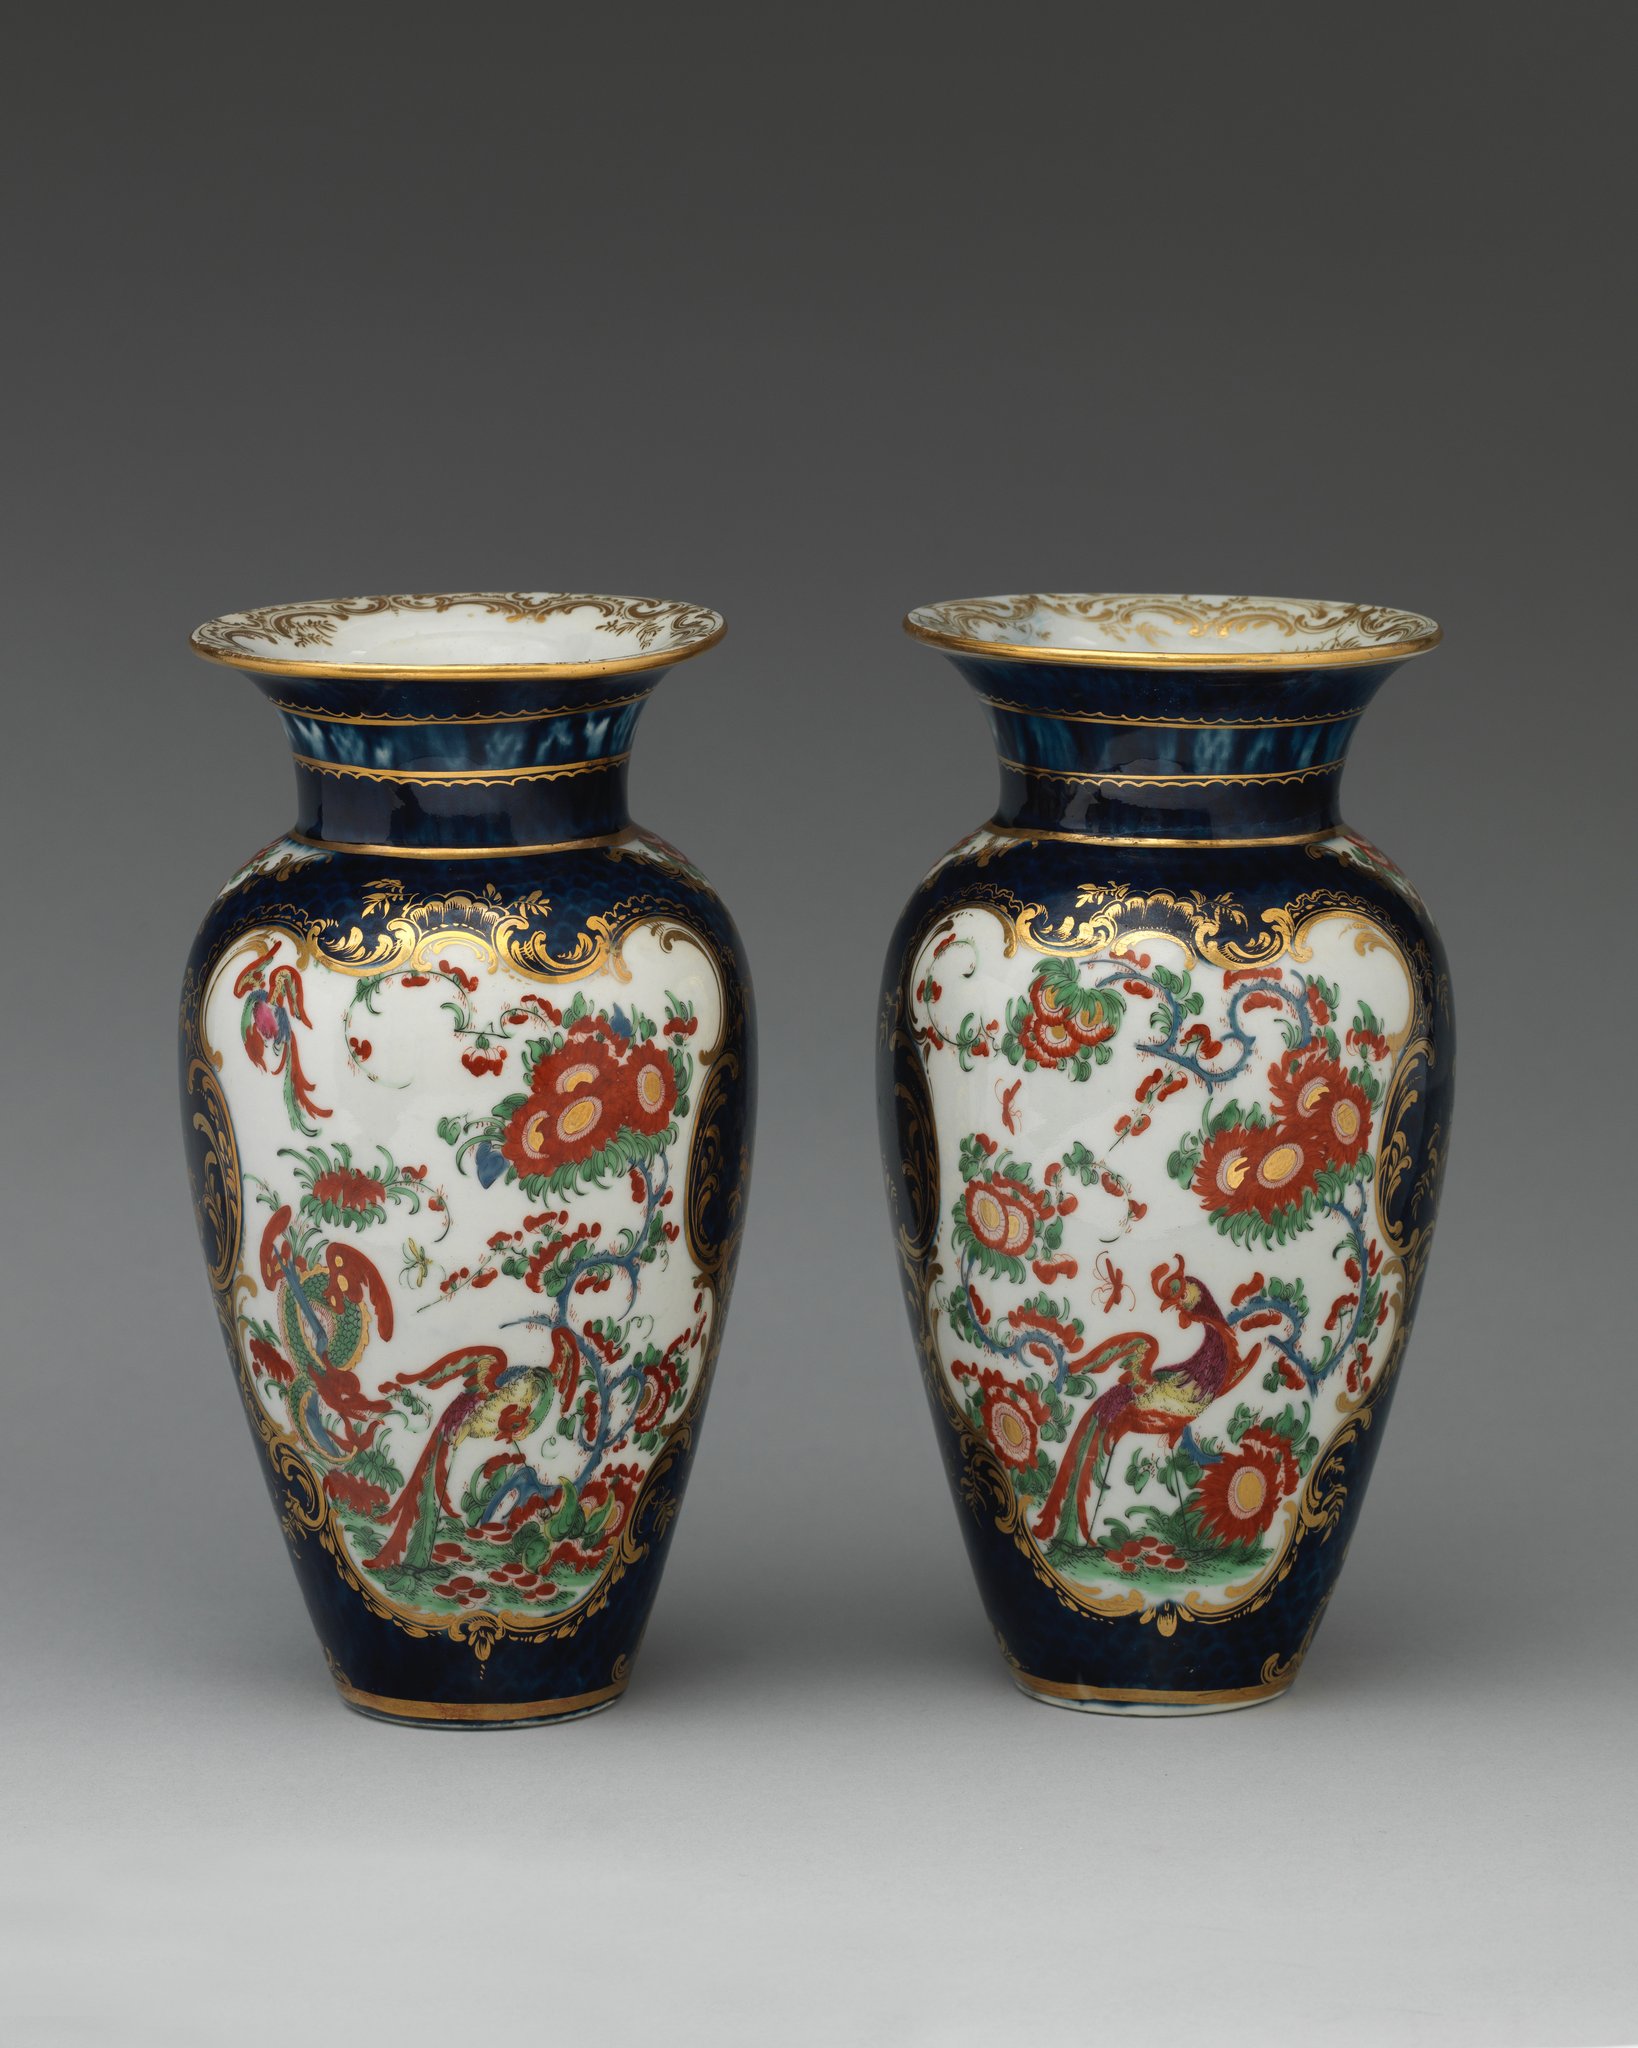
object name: vase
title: Vase (one of a pair)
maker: worcester factory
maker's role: factory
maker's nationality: british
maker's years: 1751-2008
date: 1770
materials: soft paste porcelain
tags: birds,flowers